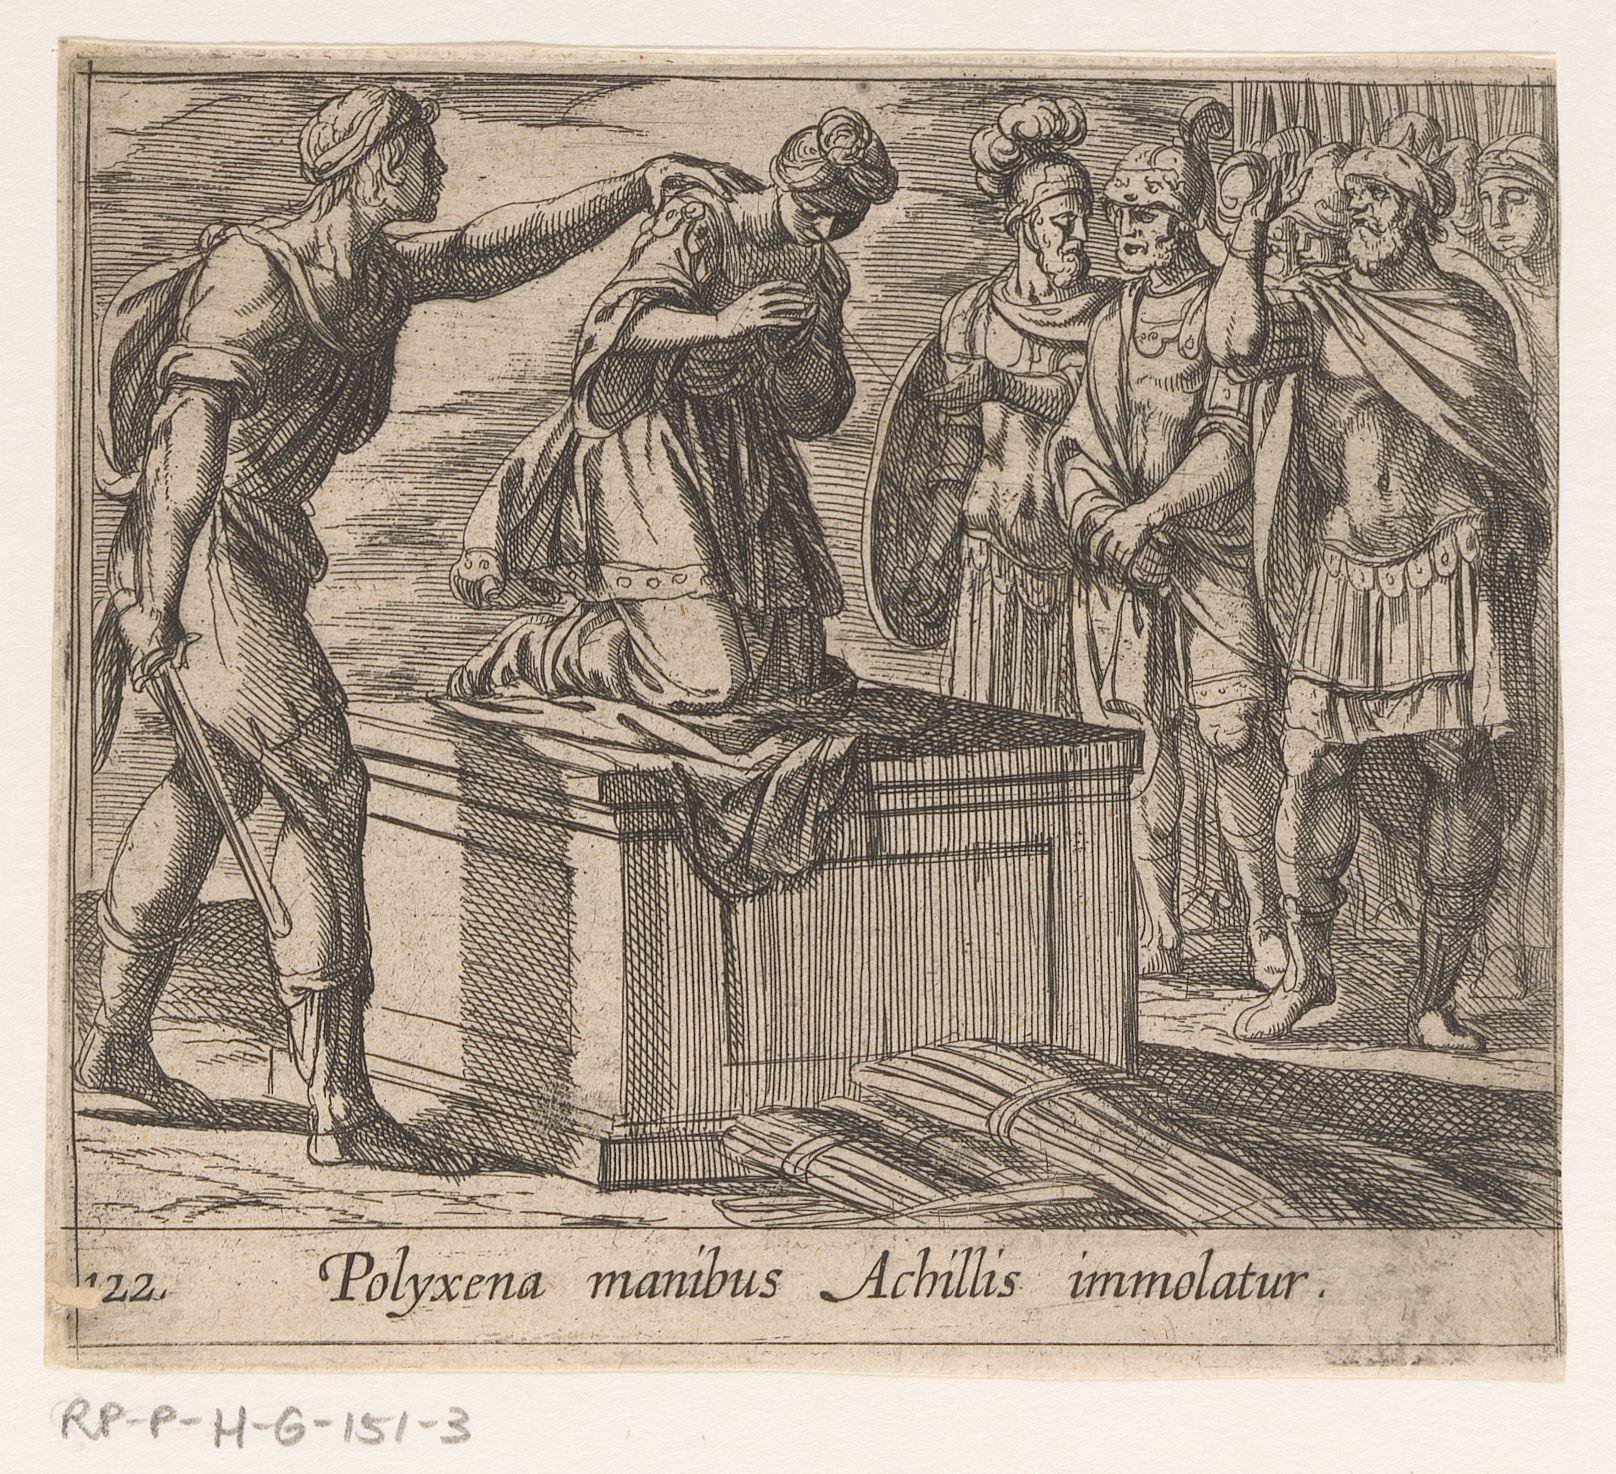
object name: print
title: Polyxena manibus Achillis immolatur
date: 1606-1638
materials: paper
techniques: etching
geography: italy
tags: polyxena is sacrificed by neoptolemus on achilles' tomb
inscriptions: collector's mark: ‘Hinloopen’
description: Deze prent maakt deel uit van een reeks van 150 prenten (+ titelprent) met voorstellingen van de Metamorfosen van Ovidius.